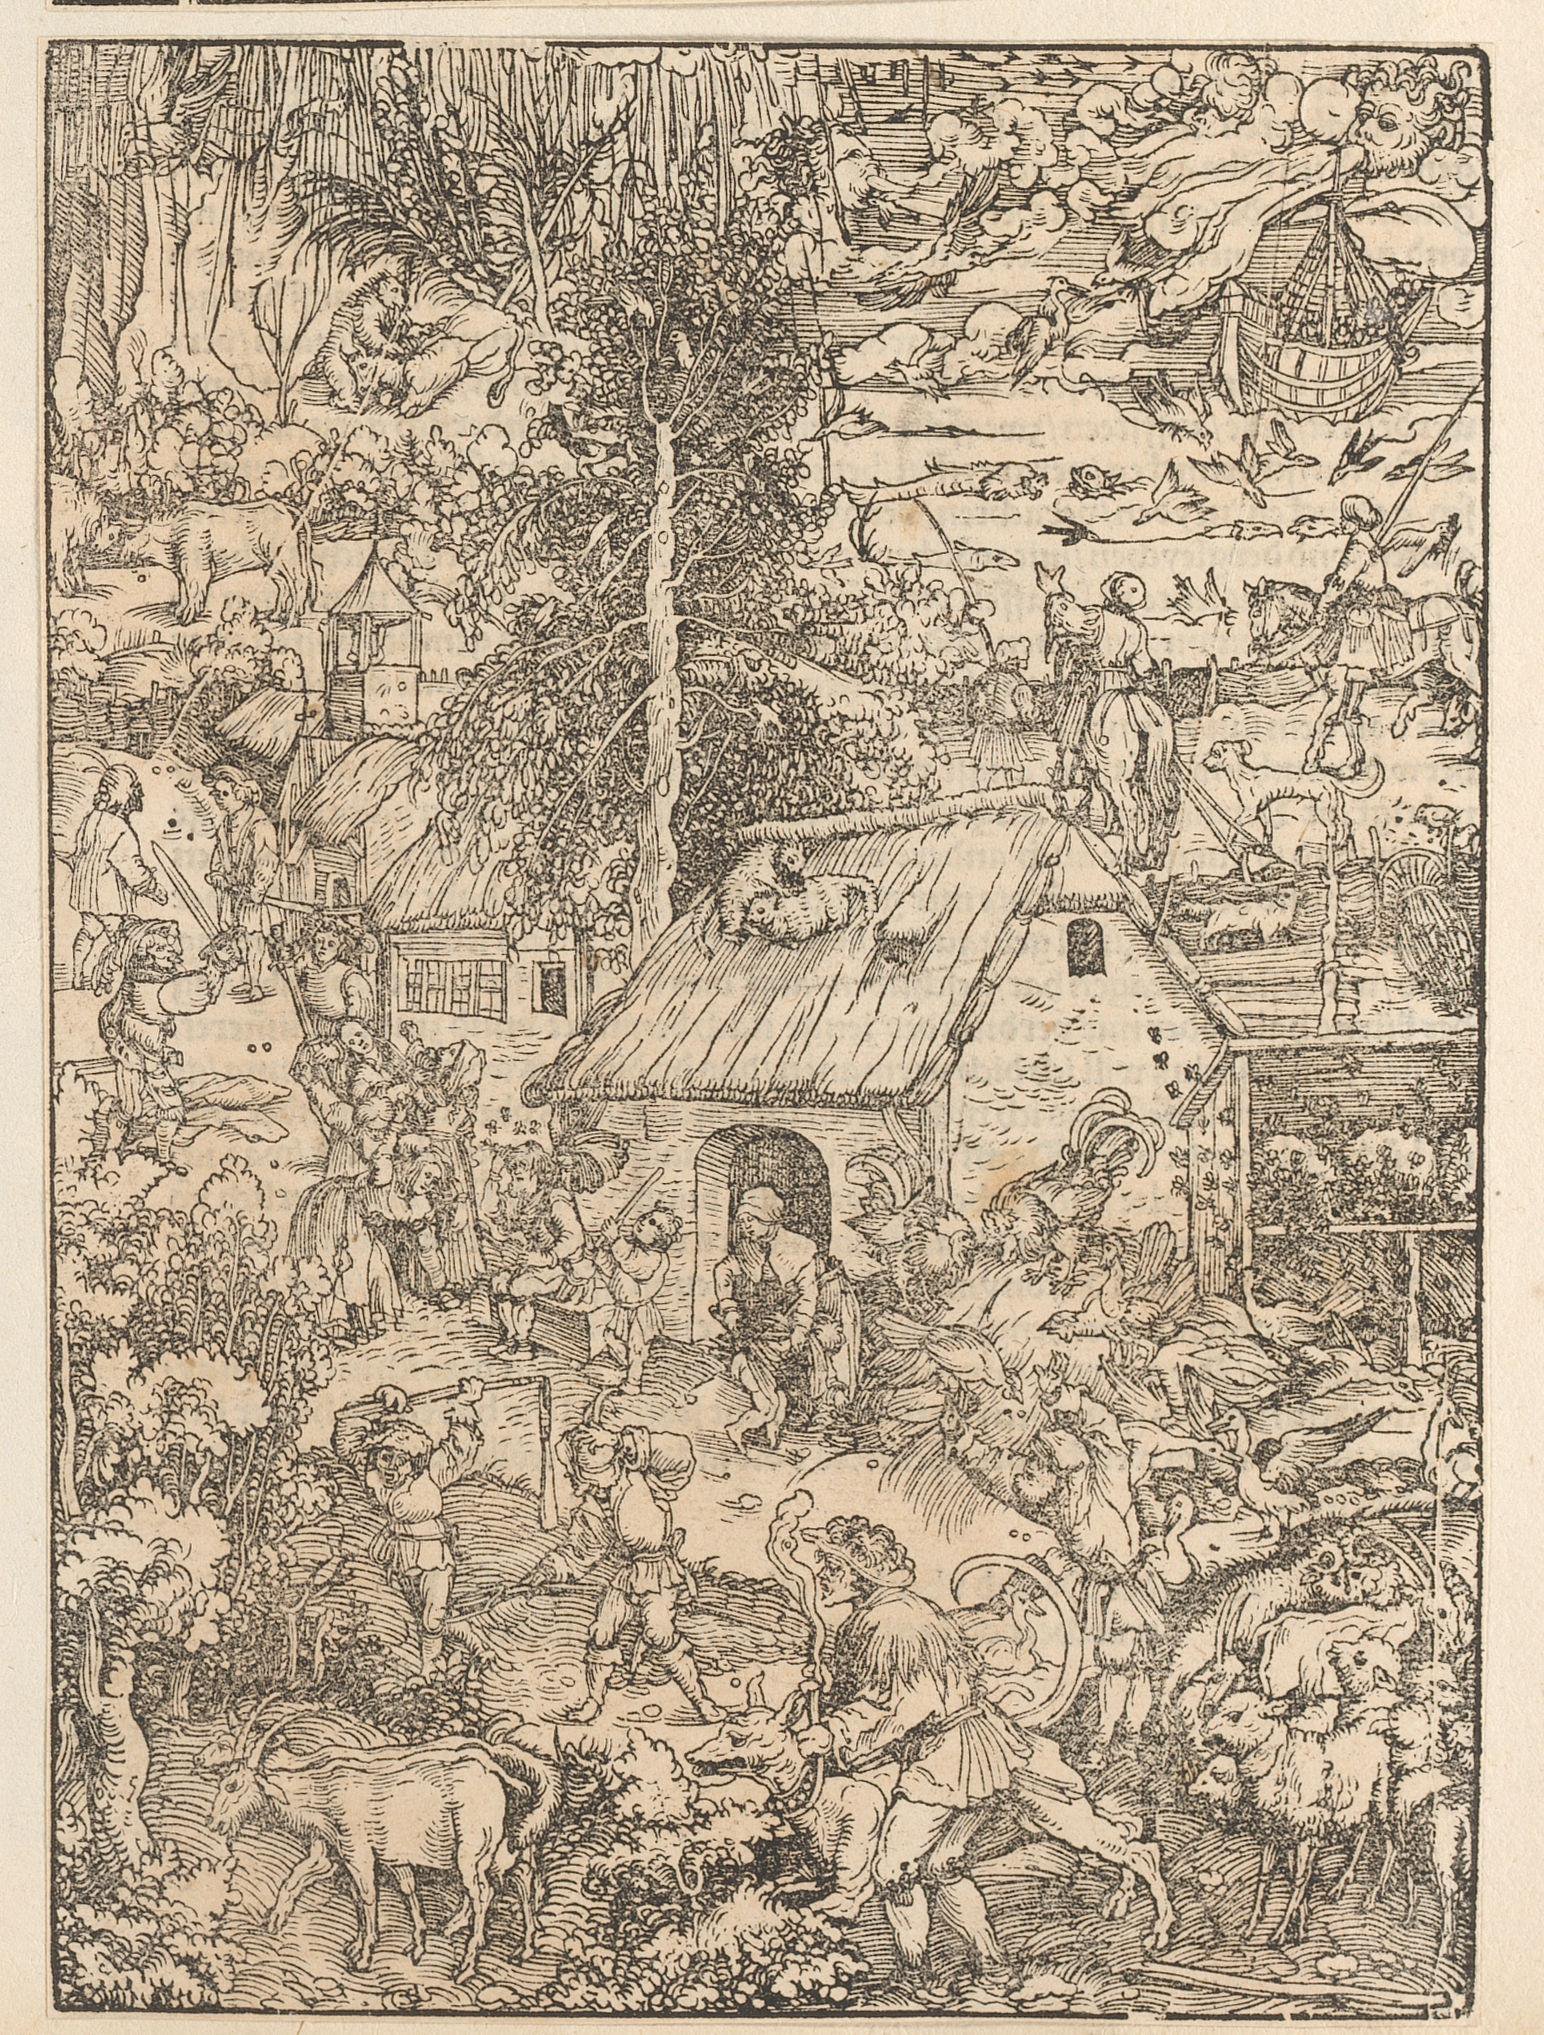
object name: album leaf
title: Mensen en dierenrijk om een huis heen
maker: Anonymous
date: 1514-1532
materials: paper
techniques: letterpress printing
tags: ideas on the animal kingdom, the vegetable world, realia ~ non-christian religions, good and bad weather, man and animal, cottage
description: Deze prent is gebruikt in: Petrarca, Francesco. Von der Artzney bayder Glück, des guten und widerwertigen: unnd weß sich ain yeder inn Gelück und Unglück halten sol (...). Augsburg: Heinrich Steiner, 1532. Deze uitgave is ook bekend onder de titel 'Trostspiegel in Glück und Unglück'.